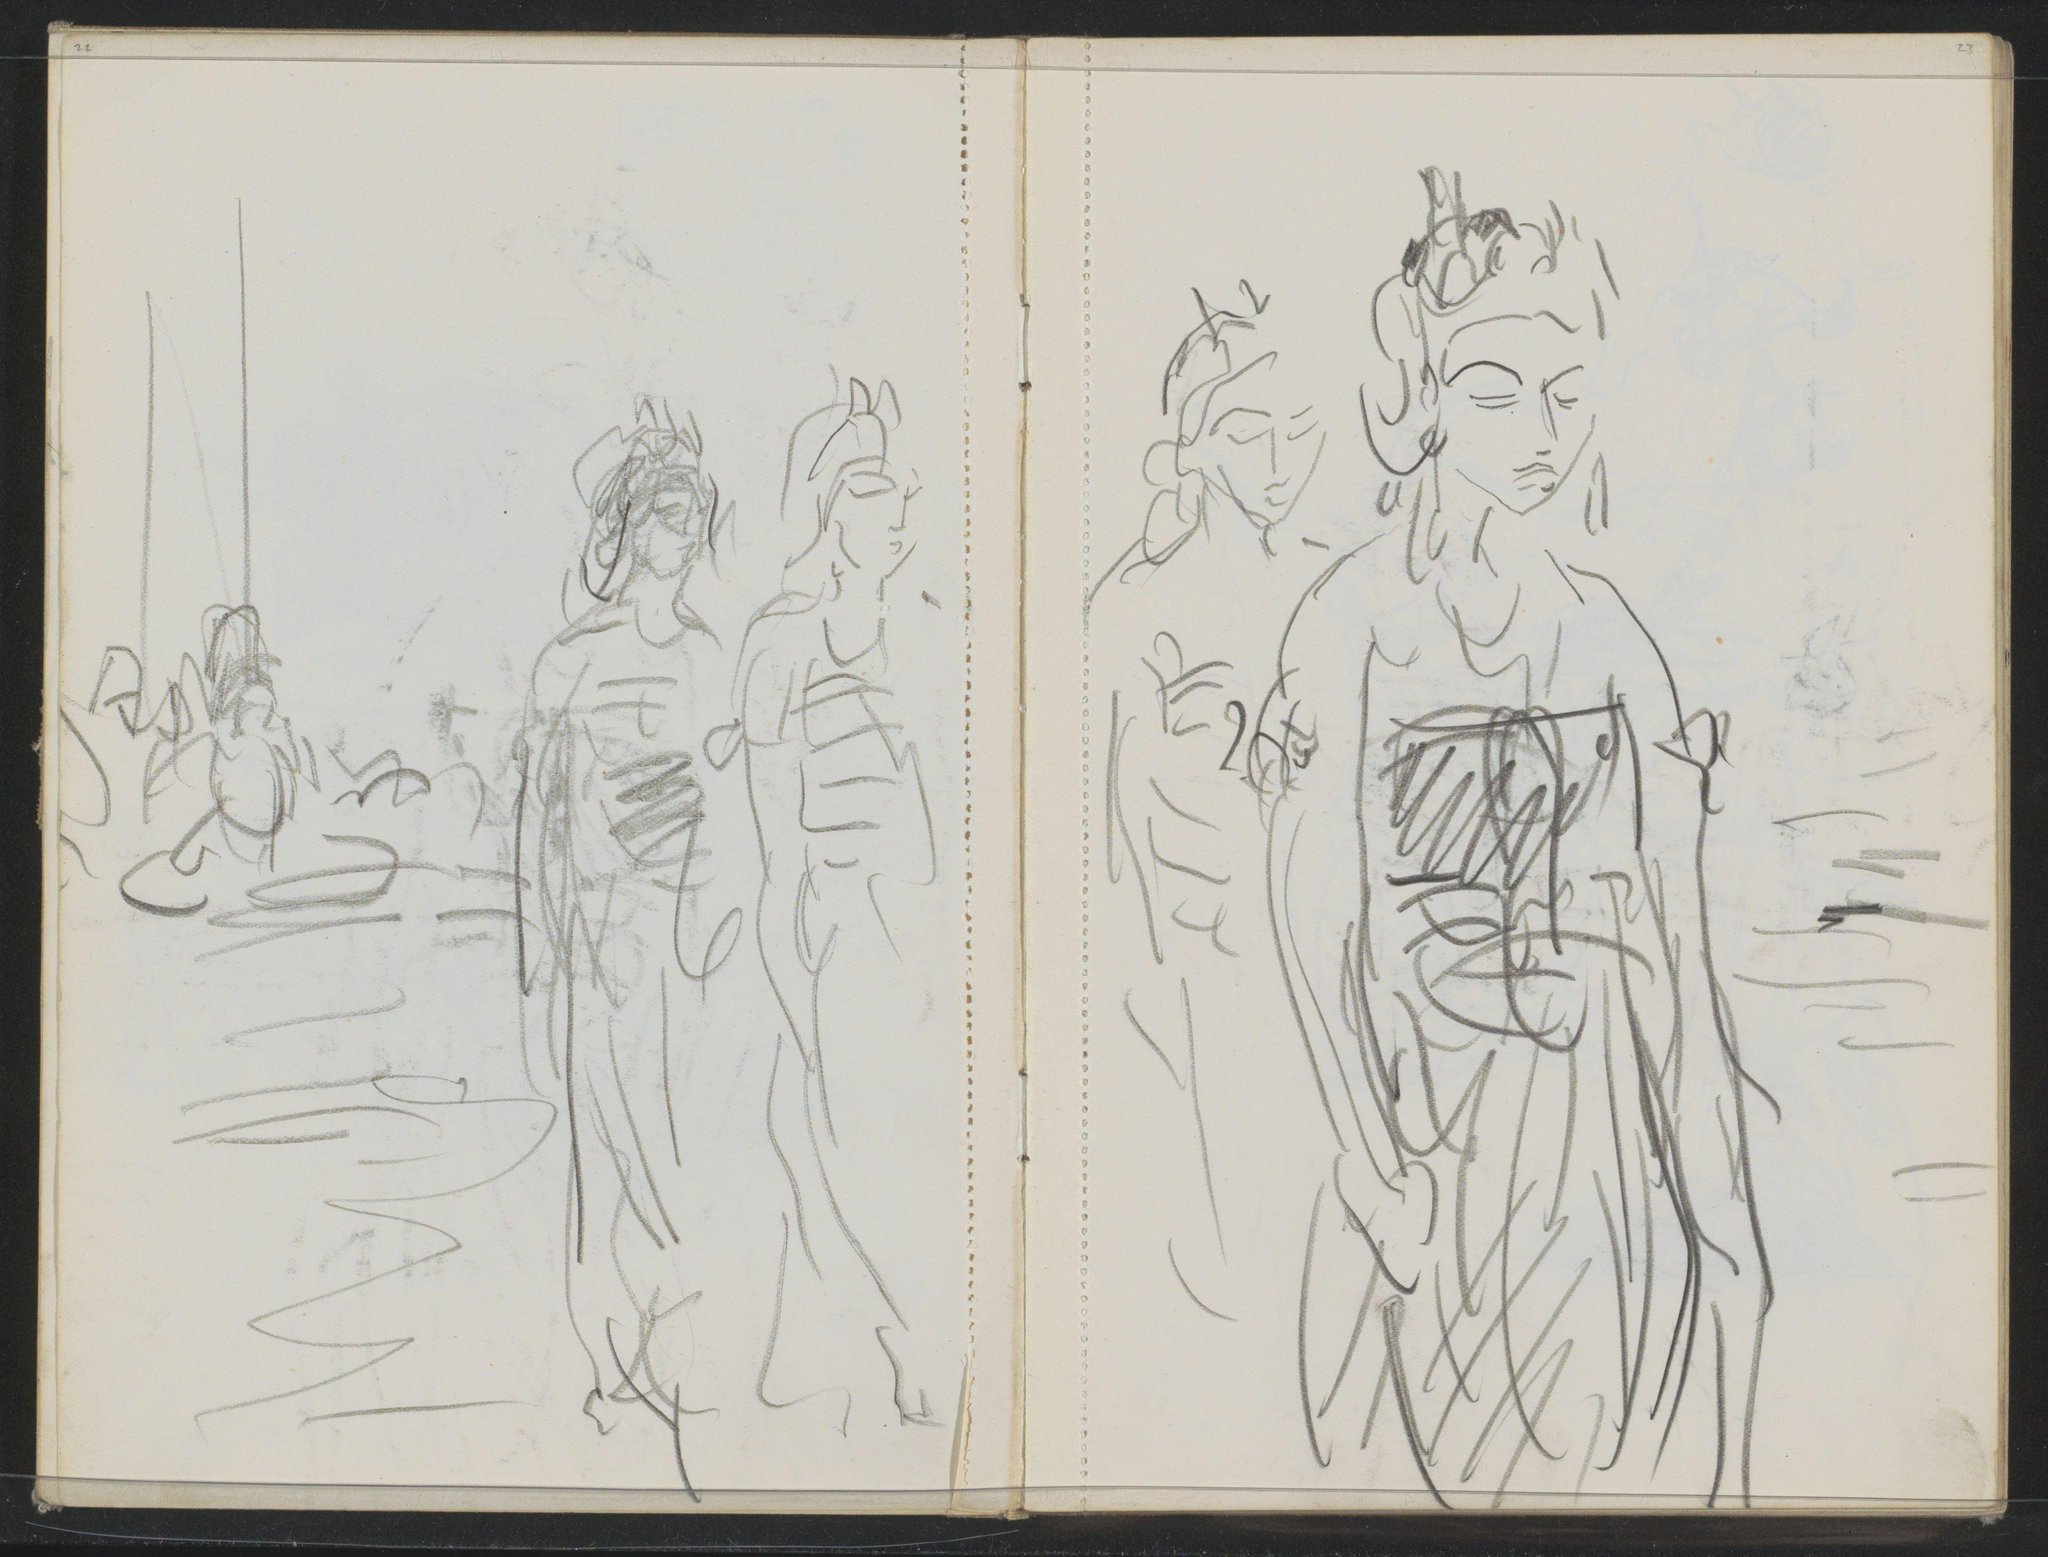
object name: sketchbook leaf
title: Vier serimpies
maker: marius bauer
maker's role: draughtsman, print maker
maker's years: 1867-1932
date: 1925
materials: paper, pencil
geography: indonesia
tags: the audience ~ art performance, folk costume, regional costume, group of women (folk dancing)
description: Op de achtergrond enkele toeschouwers. Pagina 22 en 23 uit een schetsboek met 74 bladen.